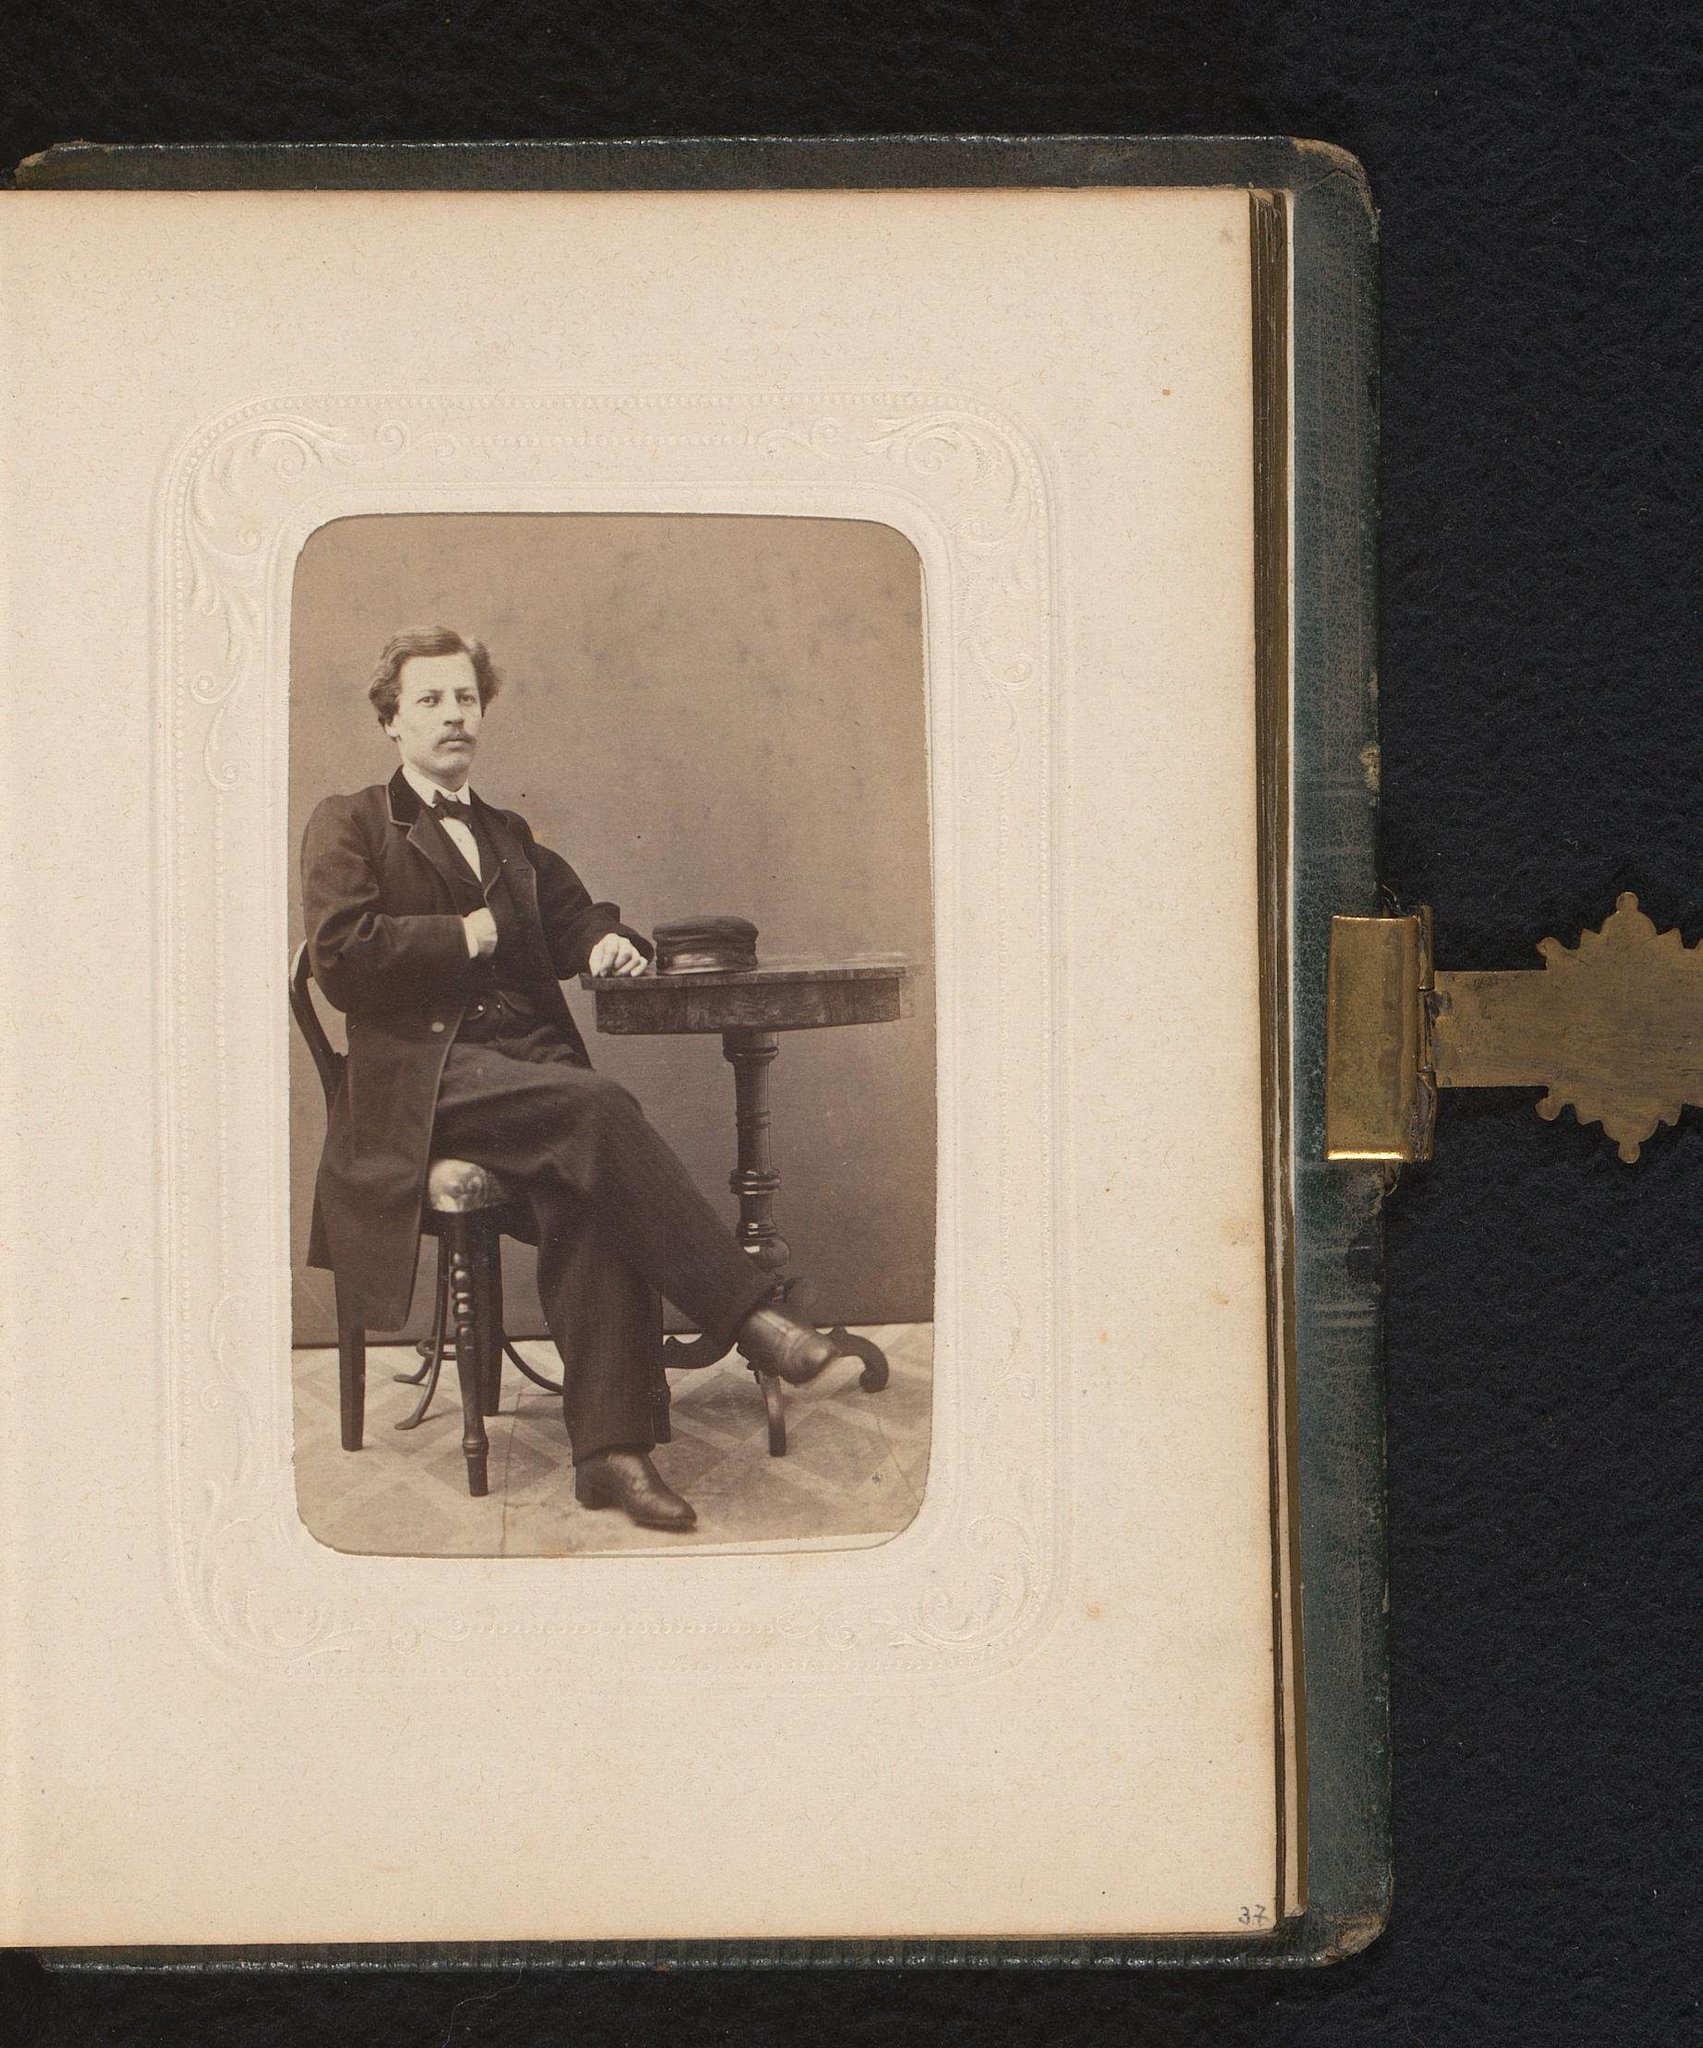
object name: carte de visite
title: Portret van een man, zittend aan een tafel met daarop een pet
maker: axel rydin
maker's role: fotograaf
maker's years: 1837-1912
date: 1860-1900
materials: cardboard, photographic support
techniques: albumen print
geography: sweden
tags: sitting figure, historical persons, table, head-gear: cap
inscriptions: inscription: ‘Fotografi/ af/ Axel Rydin/ WESTERÅS.’